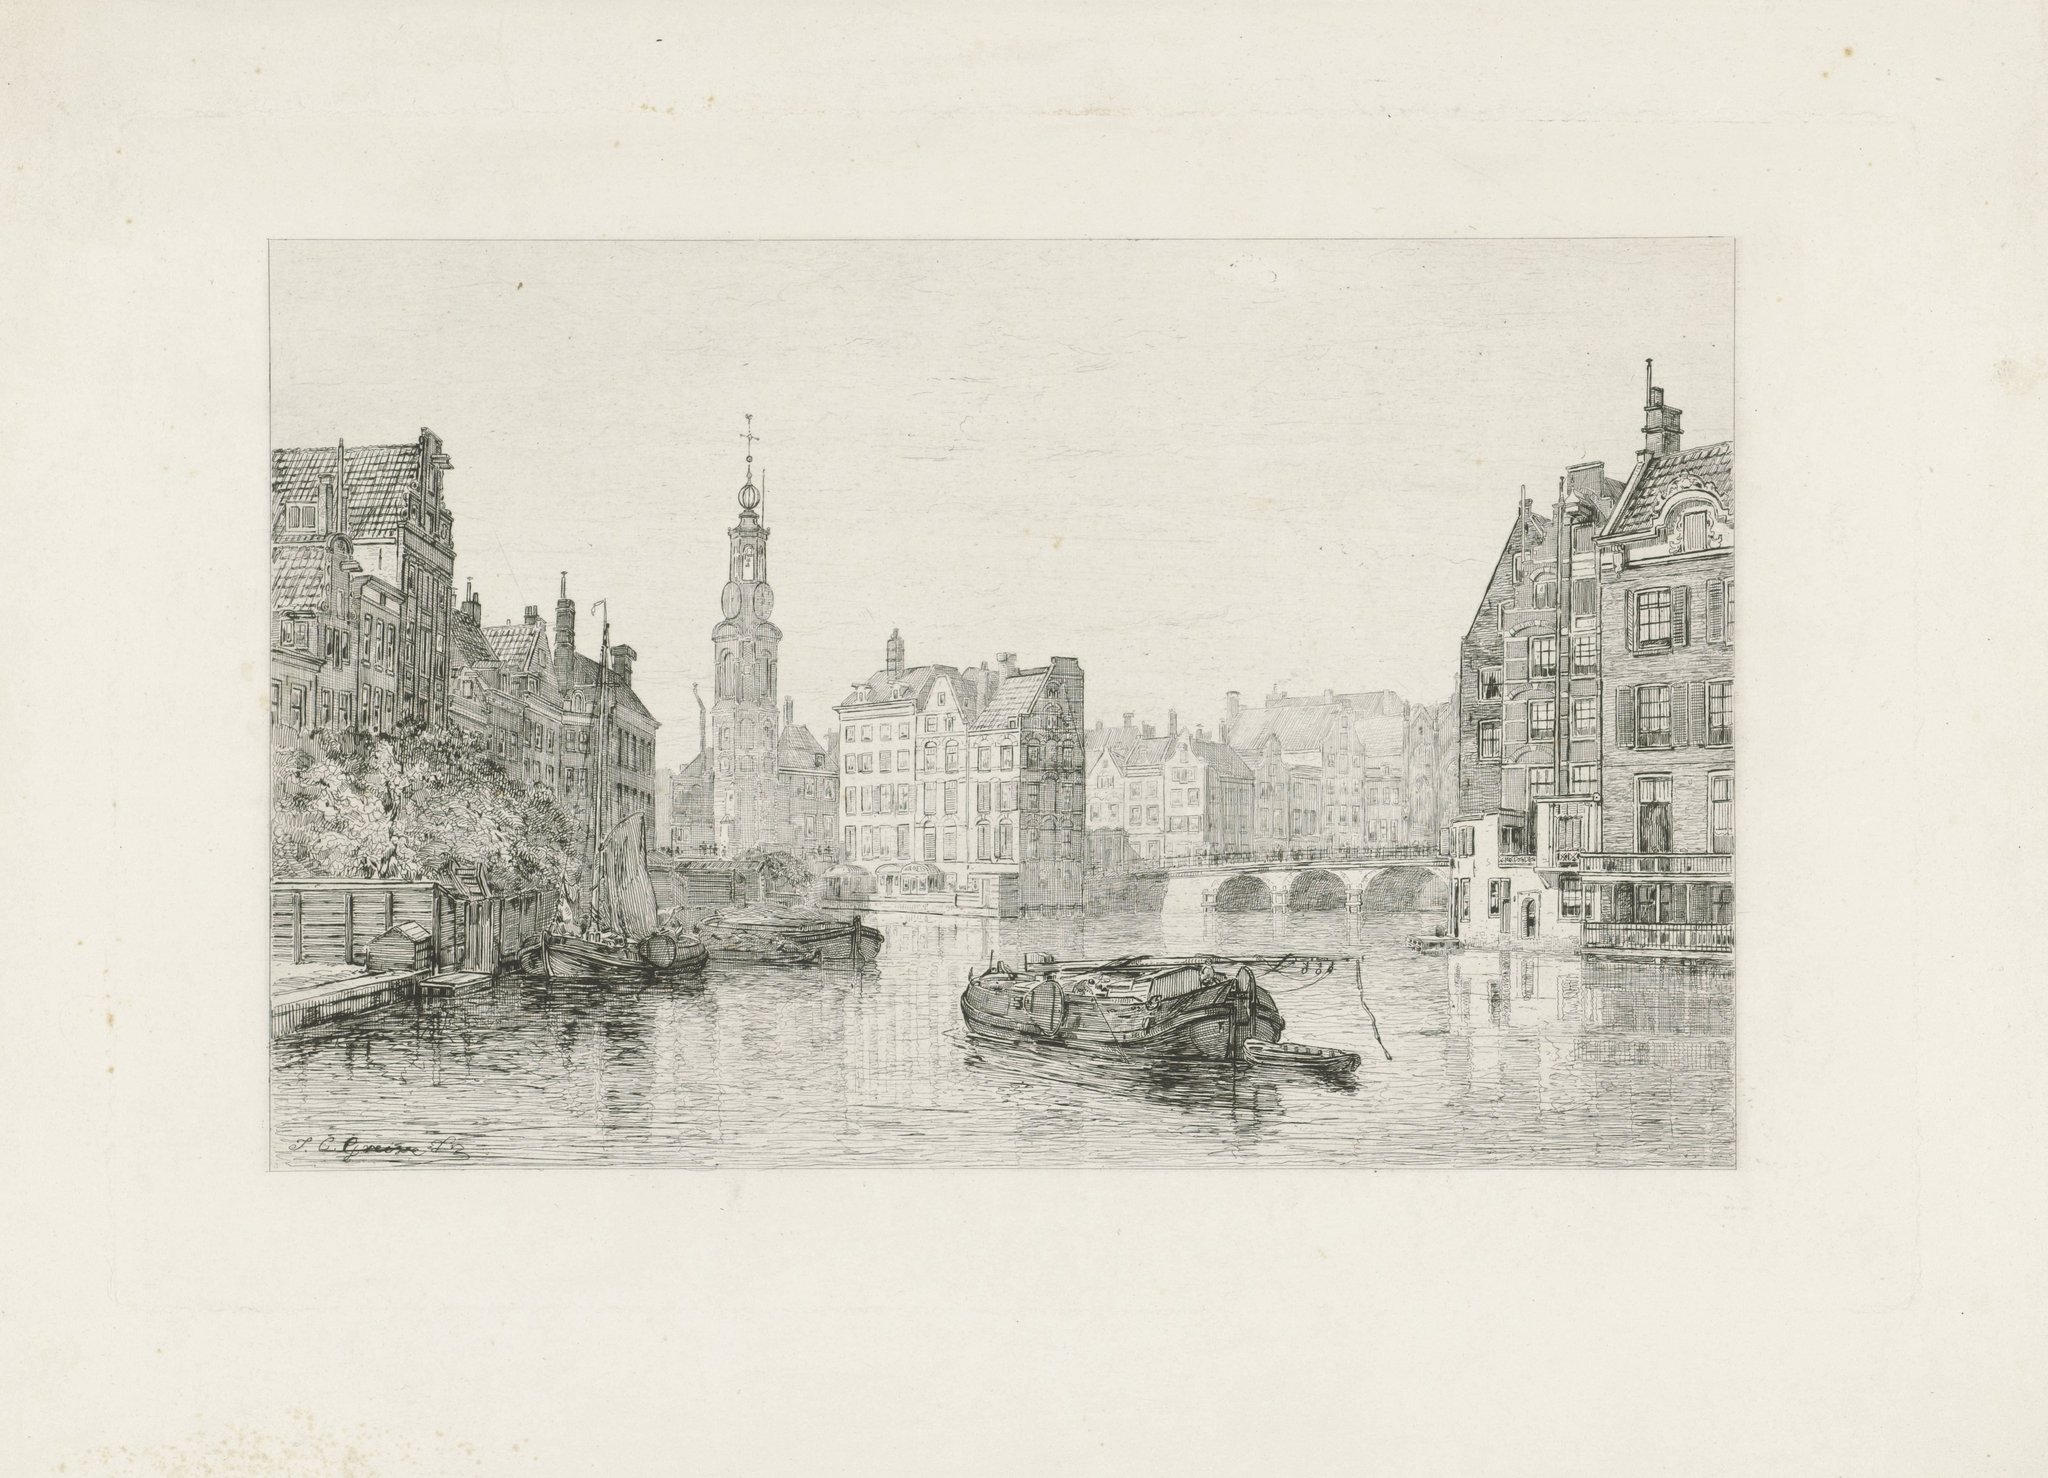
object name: print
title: Gezicht op de Munttoren in Amsterdam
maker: johan conrad greive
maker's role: draughtsman, painter, print maker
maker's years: 1837-1891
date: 1847-1891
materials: paper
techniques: etching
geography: amsterdam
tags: river (+ landscape with figures, staffage)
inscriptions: collector's mark: Lugt 2228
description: De Munttoren van Amsterdam met de Doelensluis rechts. Op de voorgrond de Binnen Amstel en een boot.